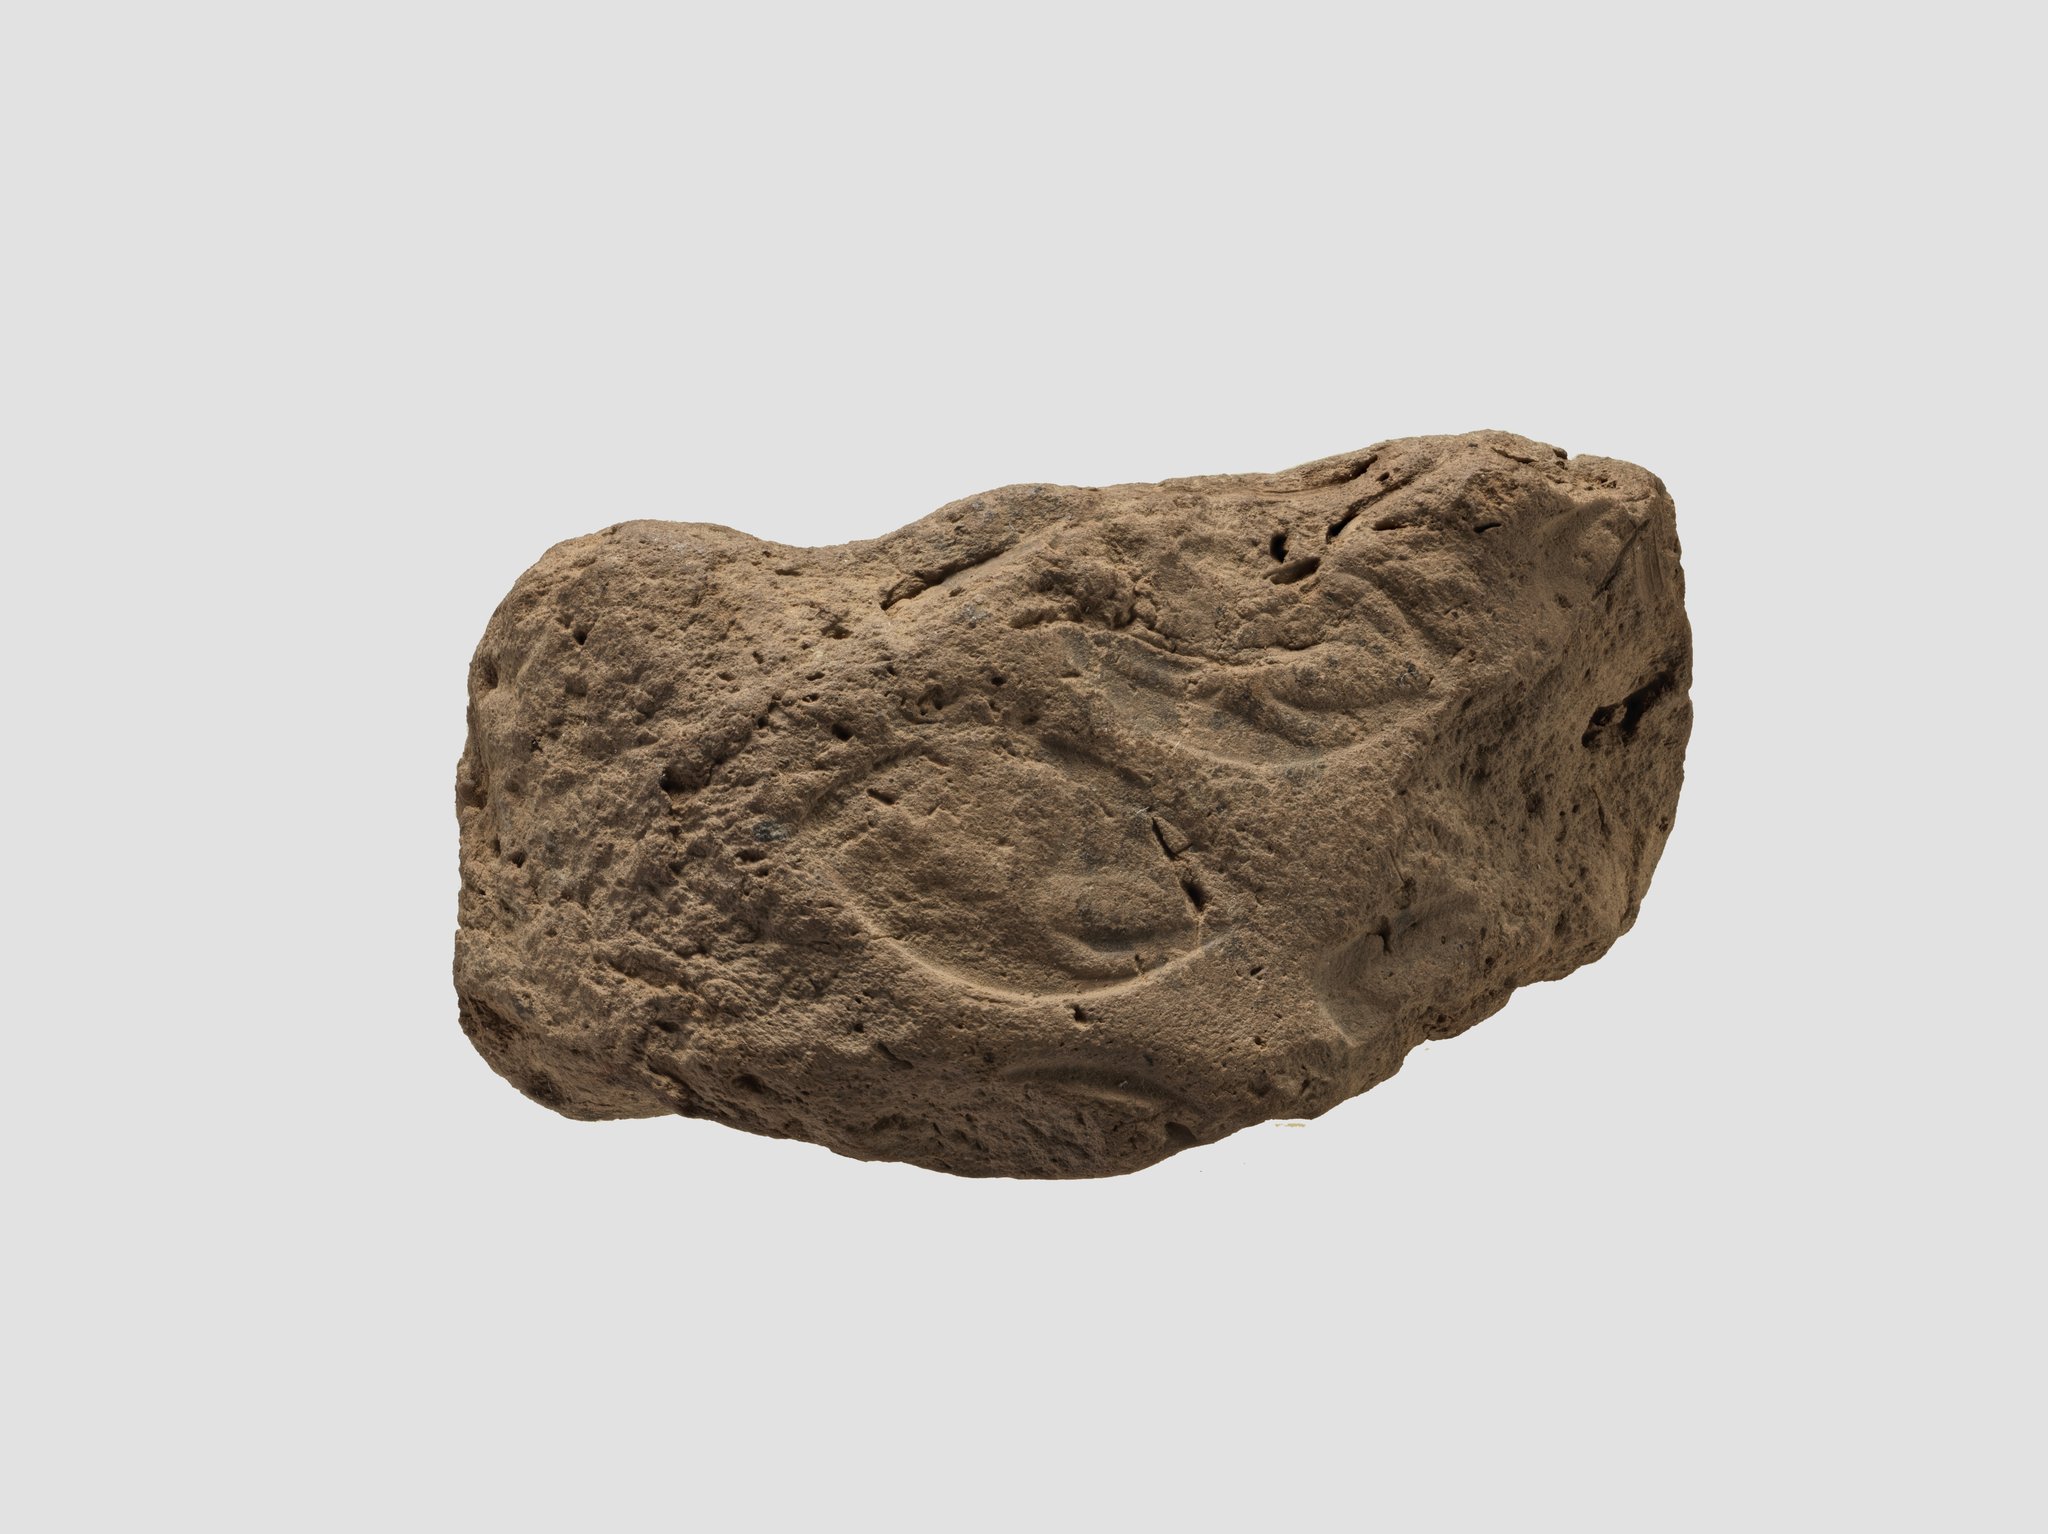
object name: bulla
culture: parthian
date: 200 BCE-100 CE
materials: clay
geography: iran